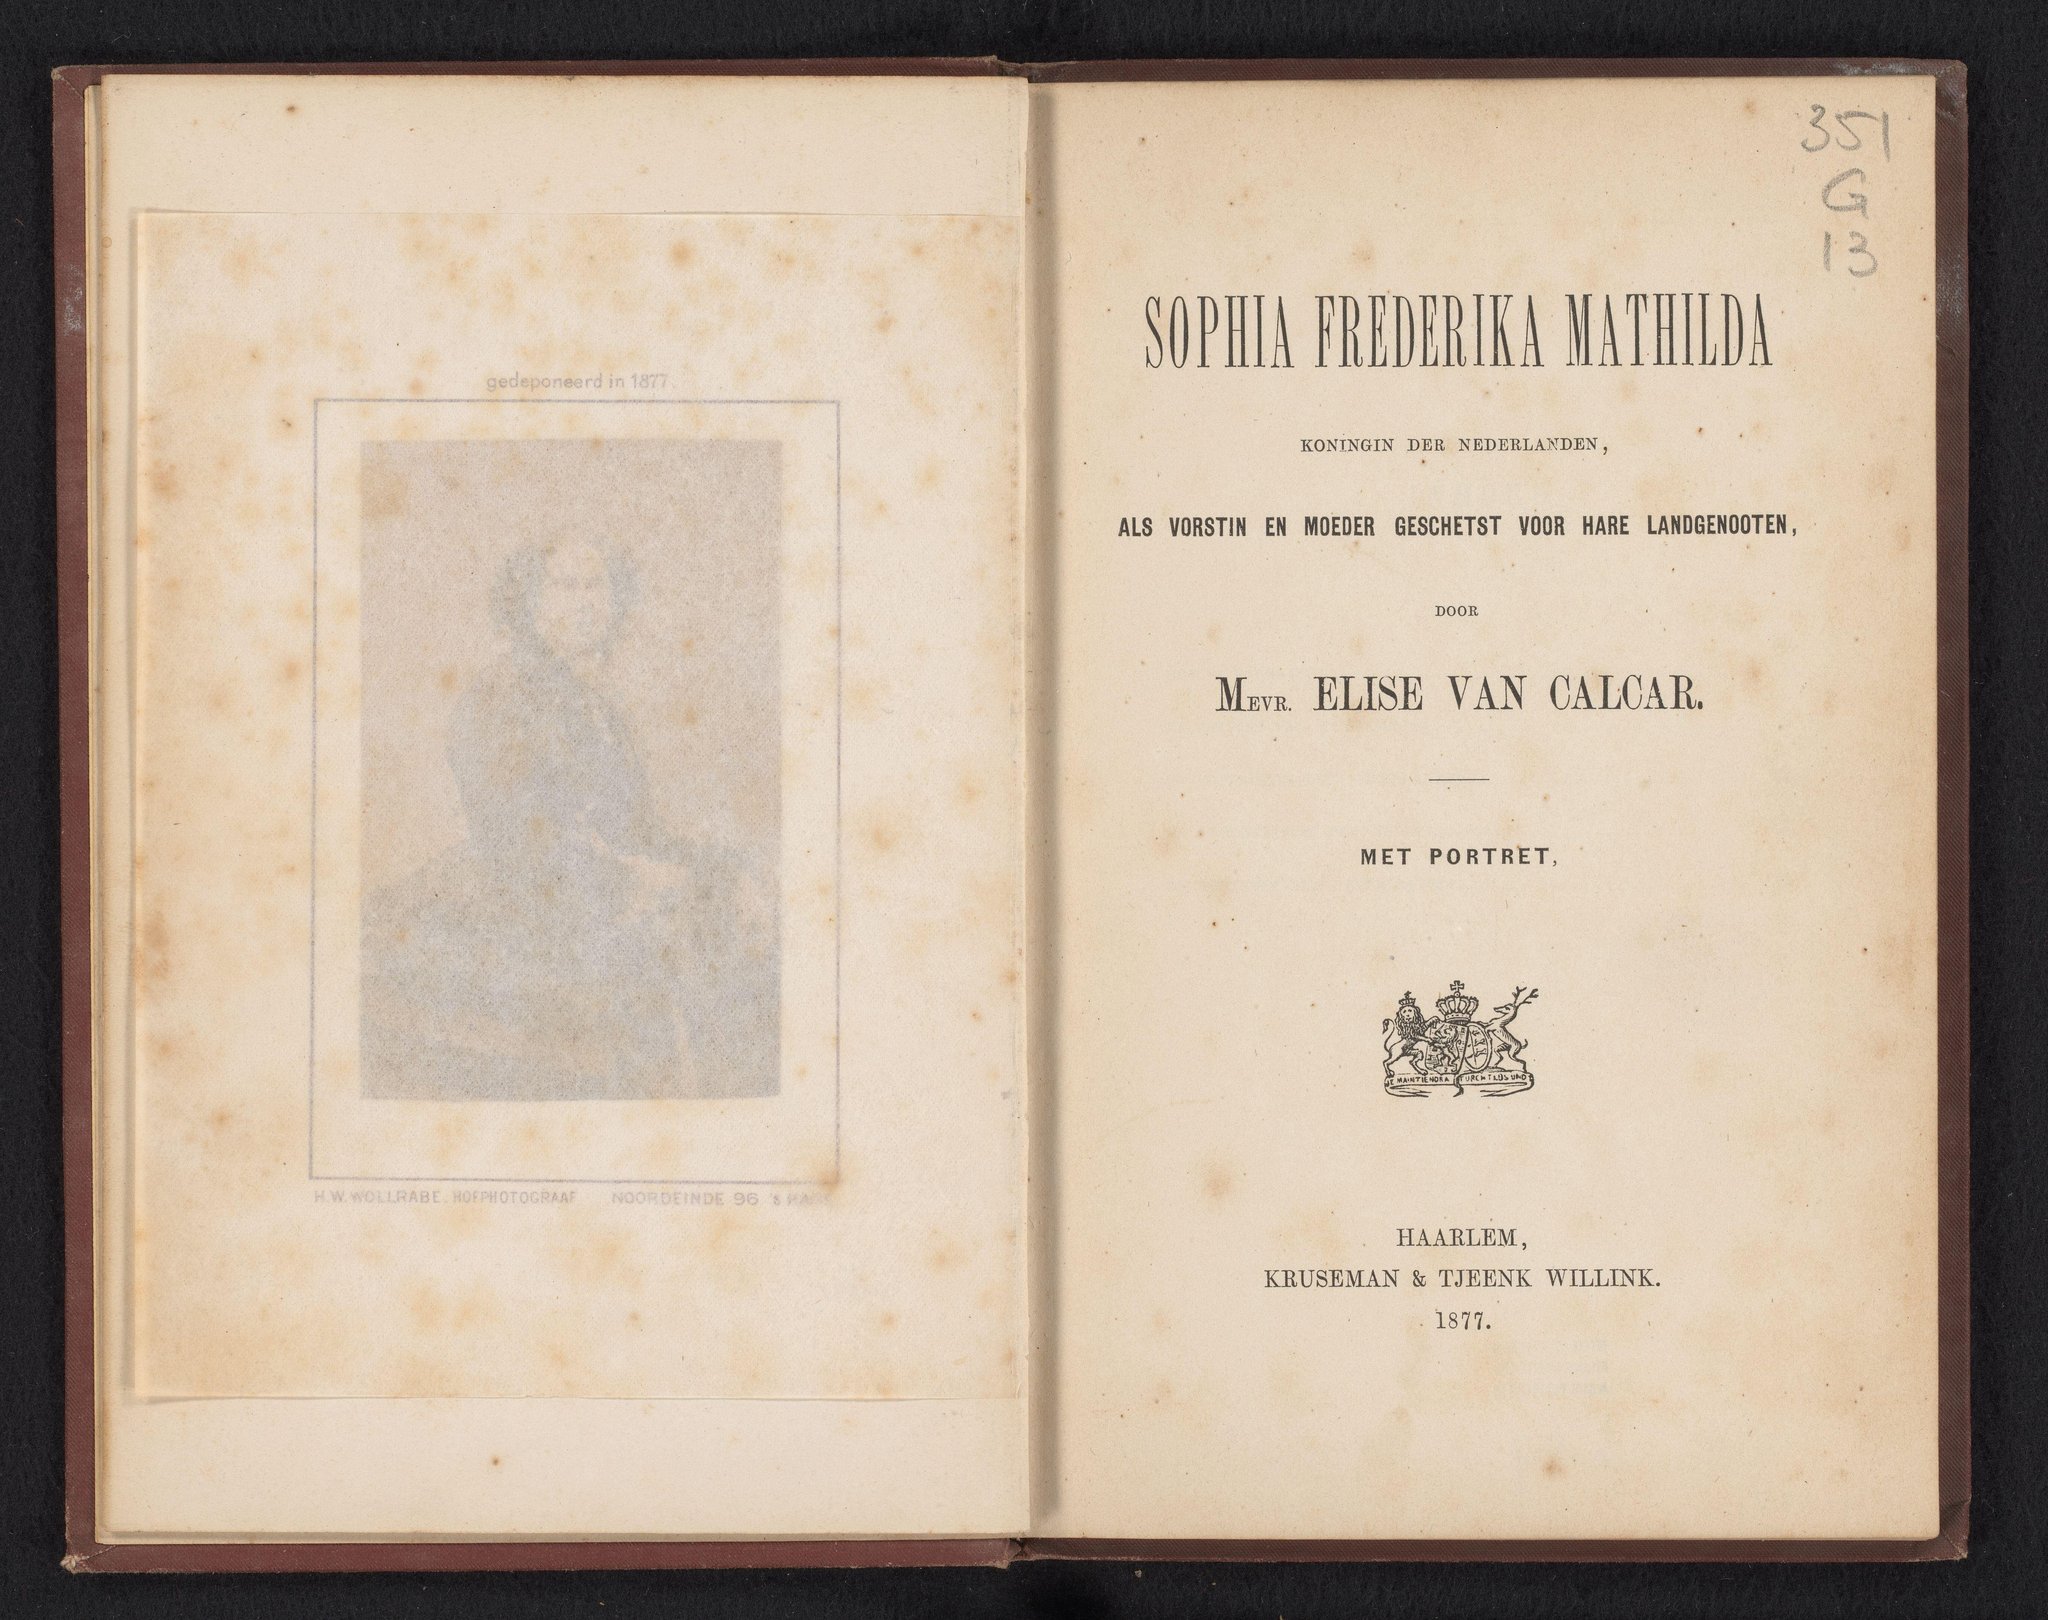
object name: book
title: Sophia Frederika Mathilda, Koningin der Nederlanden : als vorstin en moeder geschetst voor hare landgenooten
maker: elise van calcar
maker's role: schrijver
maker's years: 1822-1904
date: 1877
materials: cardboard, paper, linen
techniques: albumen print, letterpress printing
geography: haarlem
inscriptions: inscription: ‘P. Romijn.’